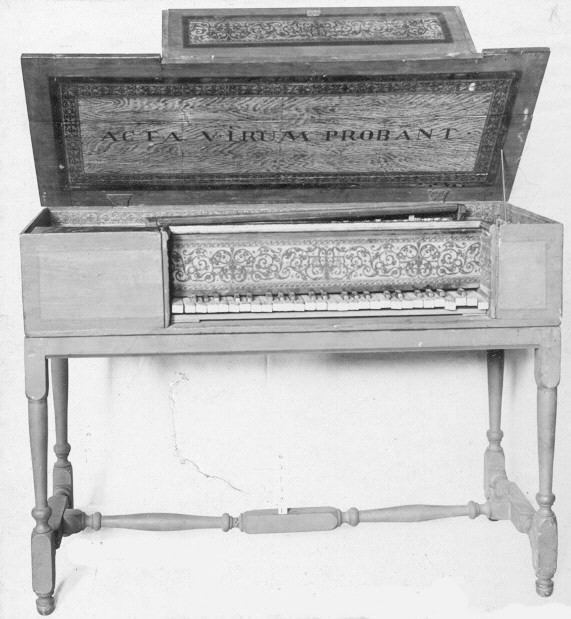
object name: virginal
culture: european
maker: c ruckers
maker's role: maker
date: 1600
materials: bone, wood